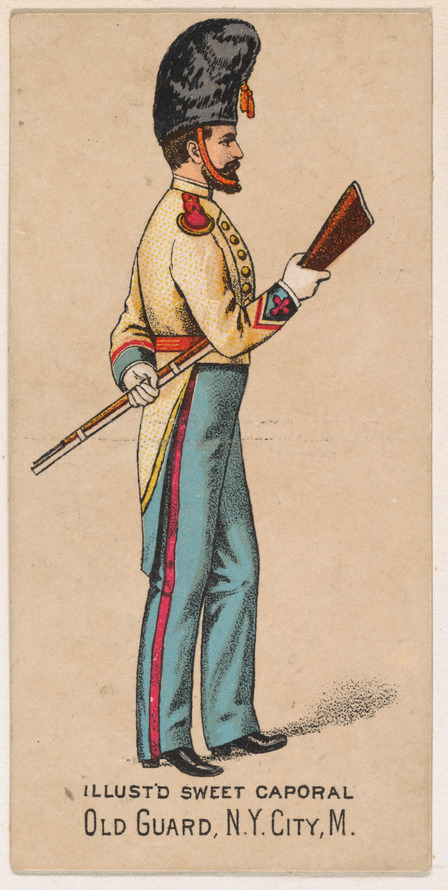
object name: print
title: Old Guard, New York City Militia, from the Military Series (N224) issued by Kinney Tobacco Company to promote Sweet Caporal Cigarettes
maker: kinney brothers tobacco company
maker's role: publisher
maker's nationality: american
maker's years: 1869-2011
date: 1888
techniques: color lithograph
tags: military,men,profiles